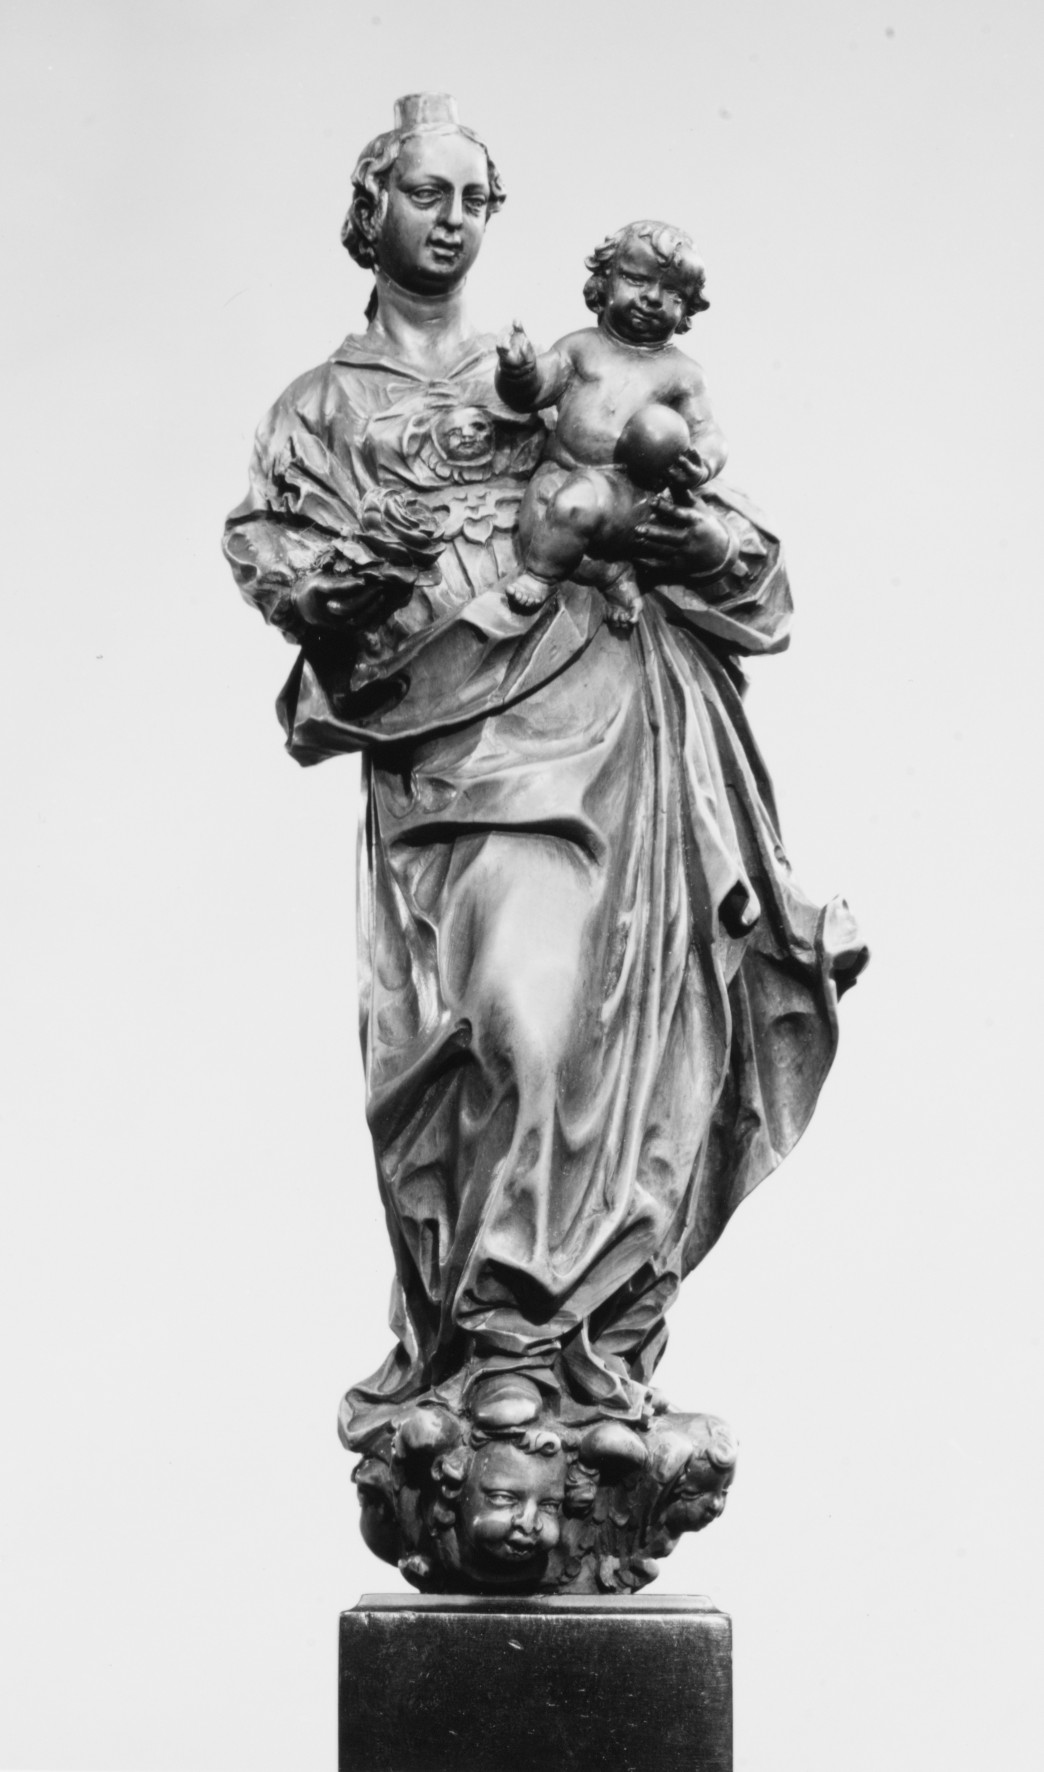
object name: statuette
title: Virgin and Child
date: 1601-1633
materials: wood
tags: faces,madonna and child